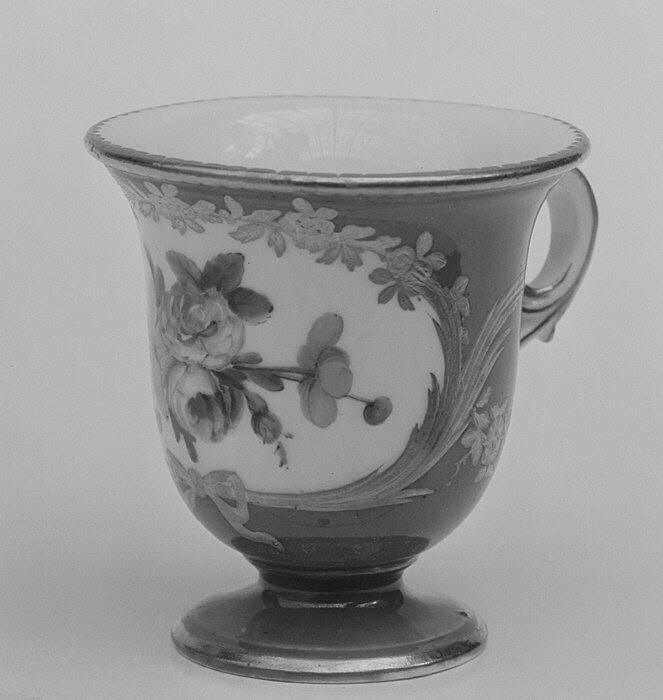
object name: ice cream cup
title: Ice cream cup (Tasse à glace) (part of a service)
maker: sèvres manufactory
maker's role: manufactory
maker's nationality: french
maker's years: 1740-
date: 1780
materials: soft paste porcelain